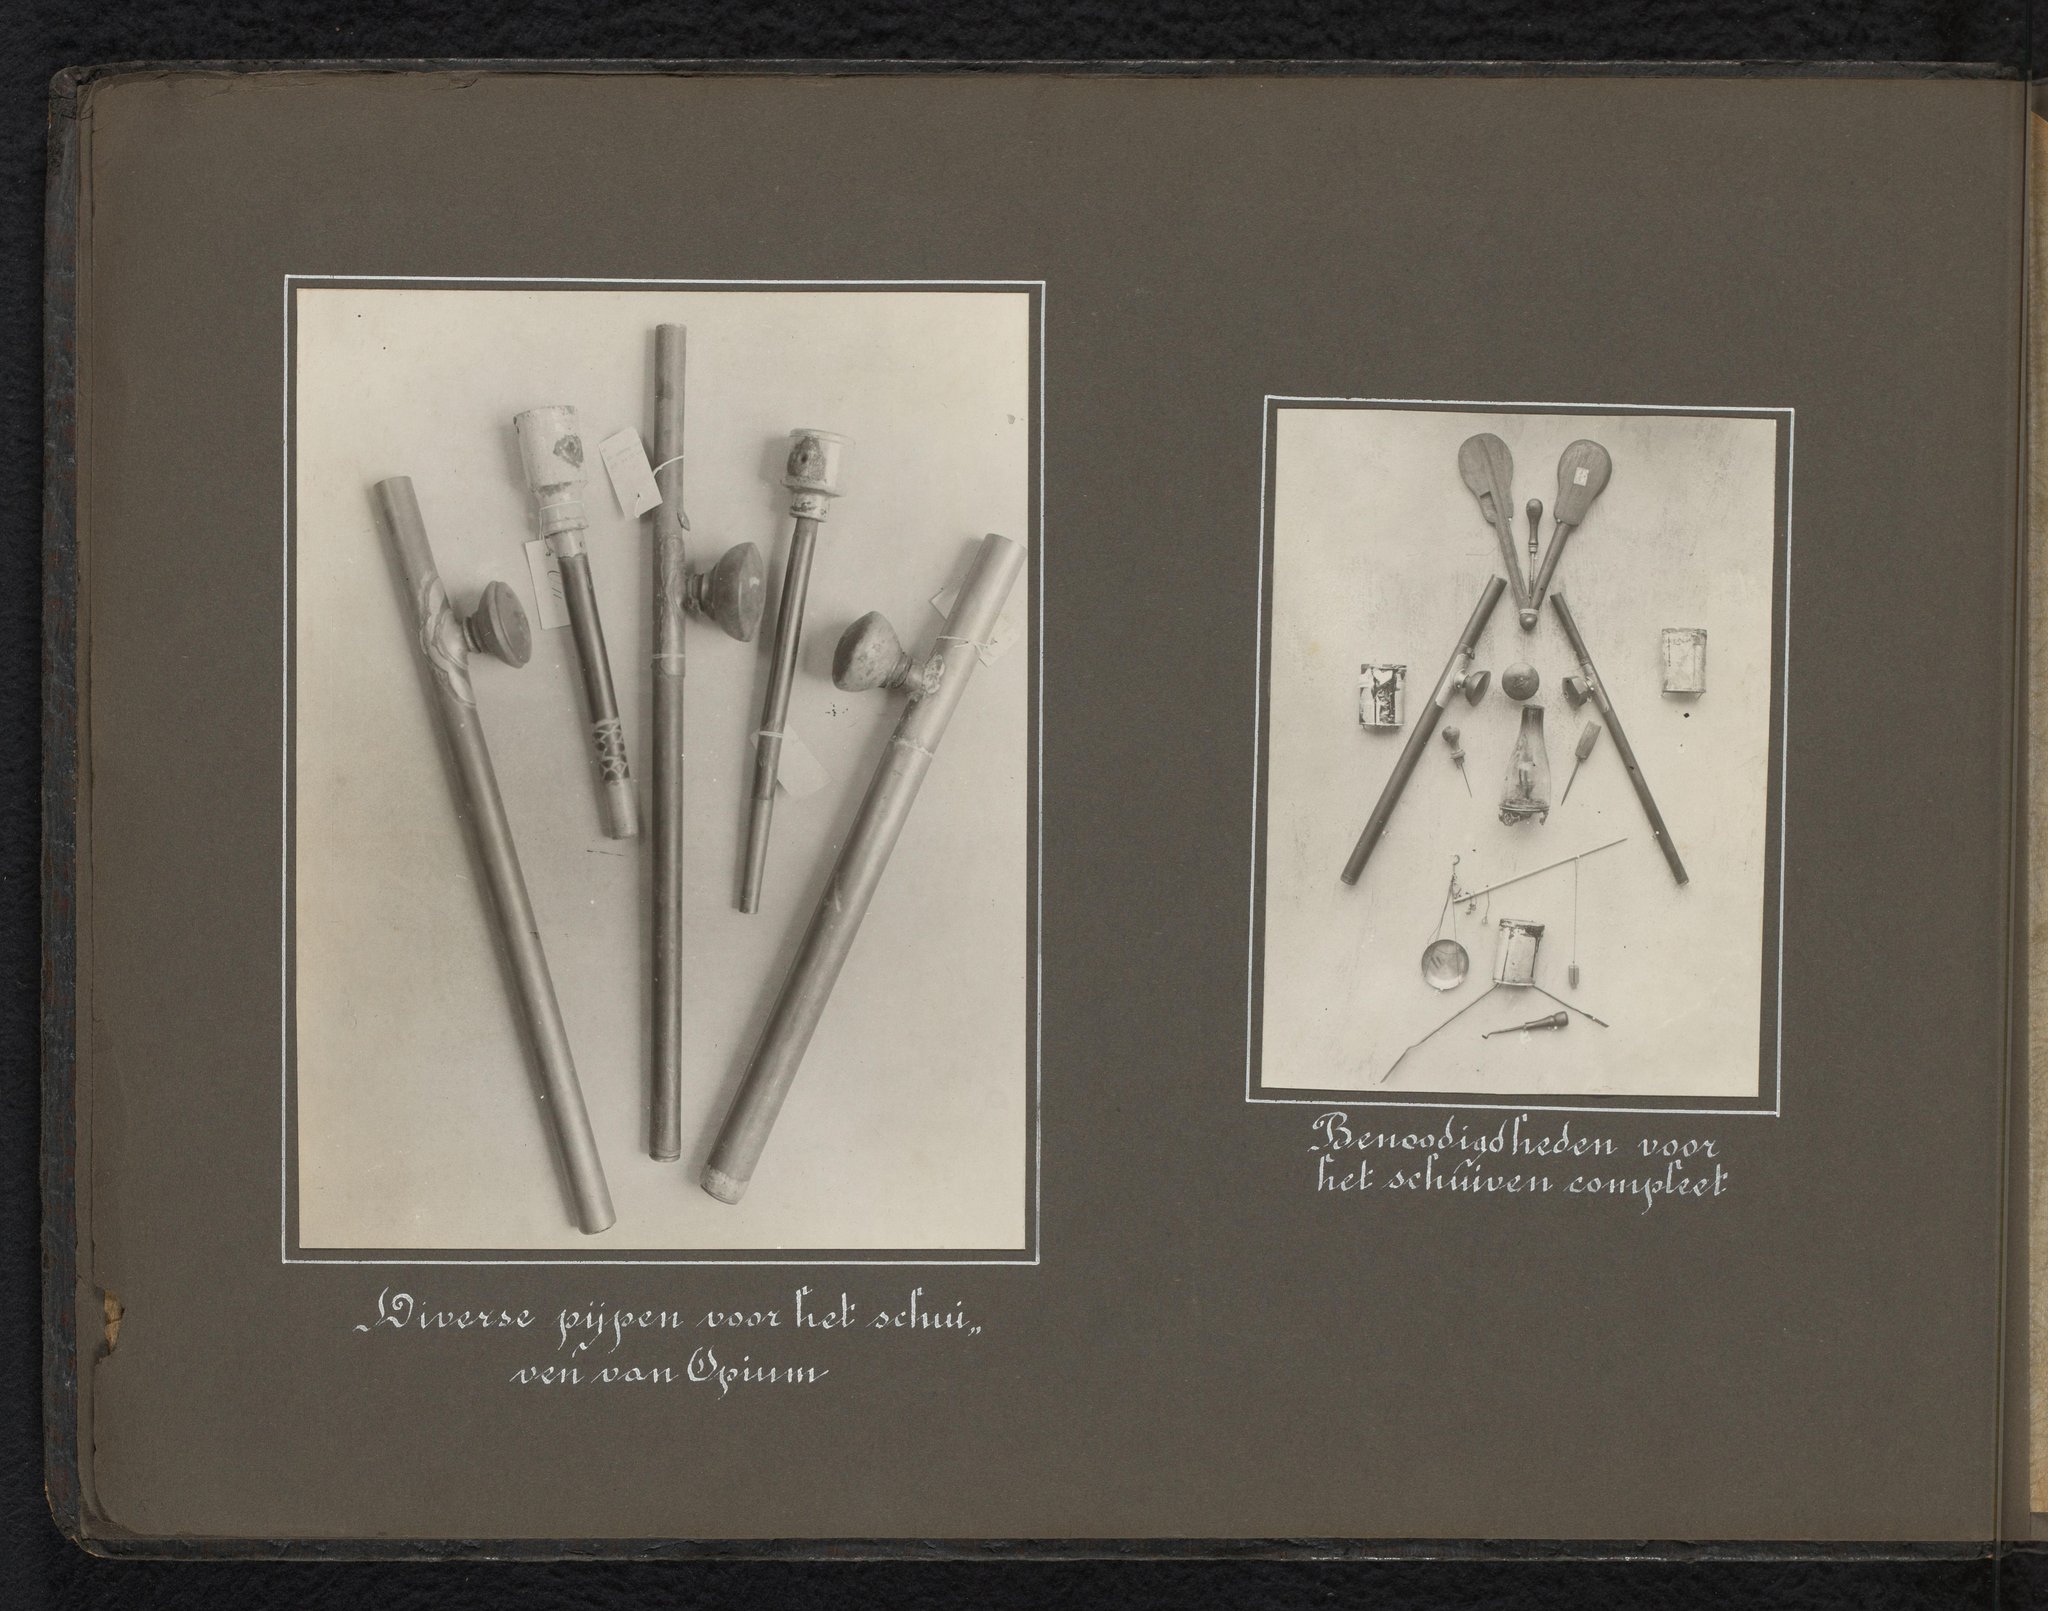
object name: album leaf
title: Benodigdheden voor het schuiven van opium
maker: Anonymous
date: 1920-1930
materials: cardboard, photographic support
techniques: gelatin silver print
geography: dutch east indies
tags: opium, trade and smuggling of drugs, policeman, constable, dutch east indies, the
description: Albumblad met twee foto's van pijpen en andere benodigdheden voor het schuiven van opium. Onderdeel van het fotoalbum uit 1930 met politiefoto's over de opiumsmokkel in Indië.